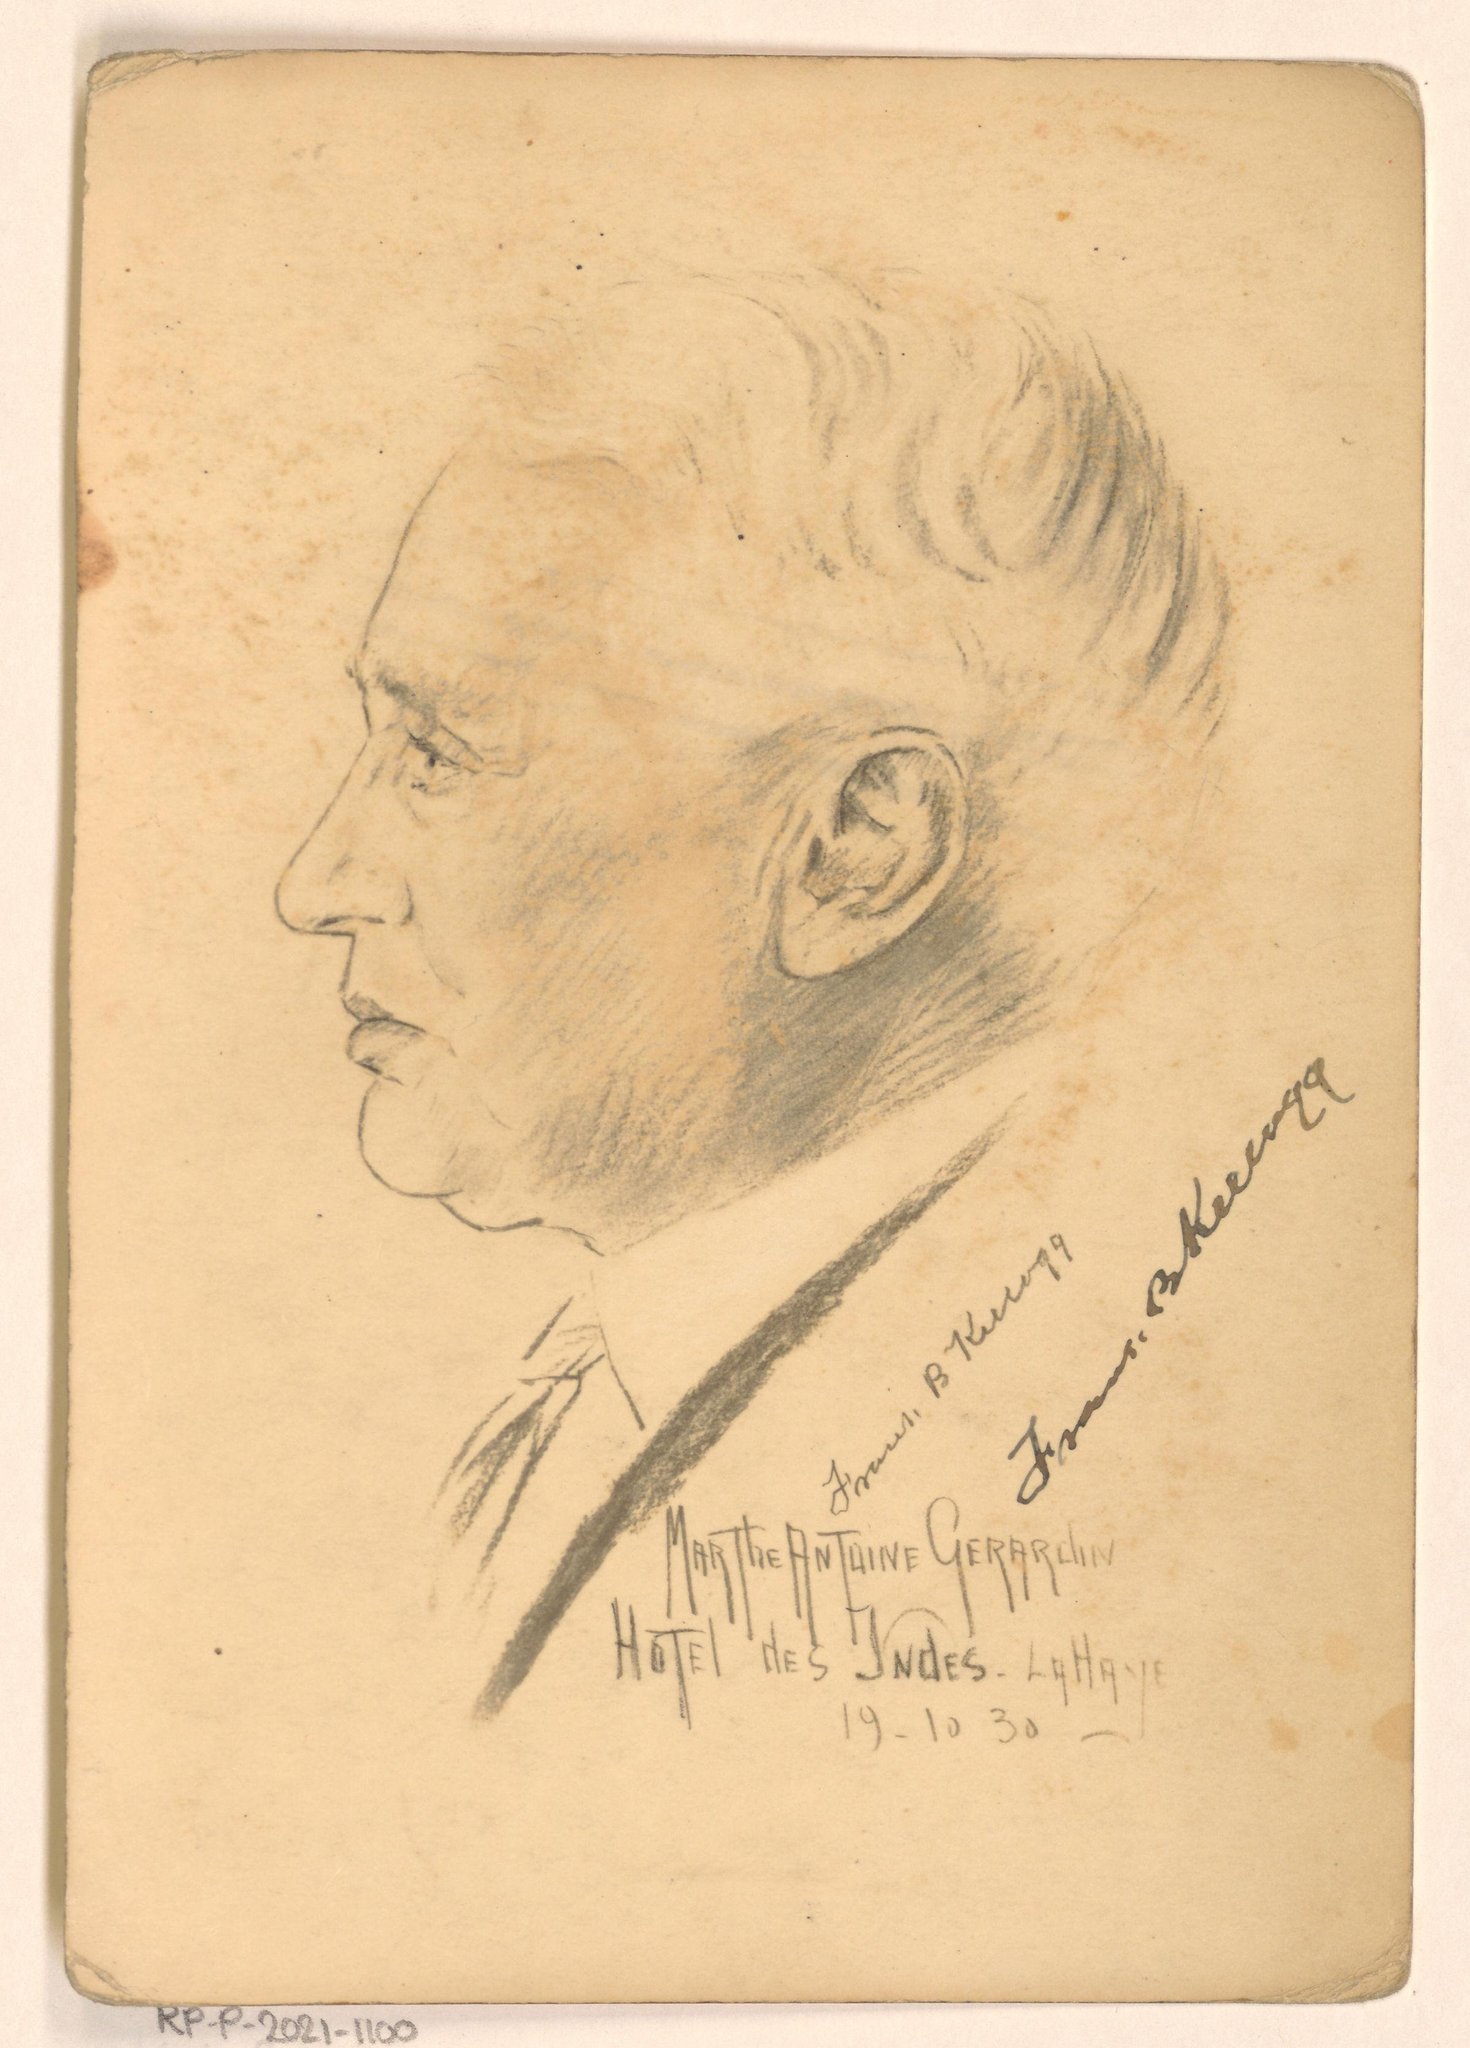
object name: print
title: Portret van Frank Billings Kellogg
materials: cardboard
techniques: lithograph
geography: the hague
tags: politician, historical persons, politician, e.g. party leader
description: Onder het portret een facsimile van de handtekening van de geportretteerde.